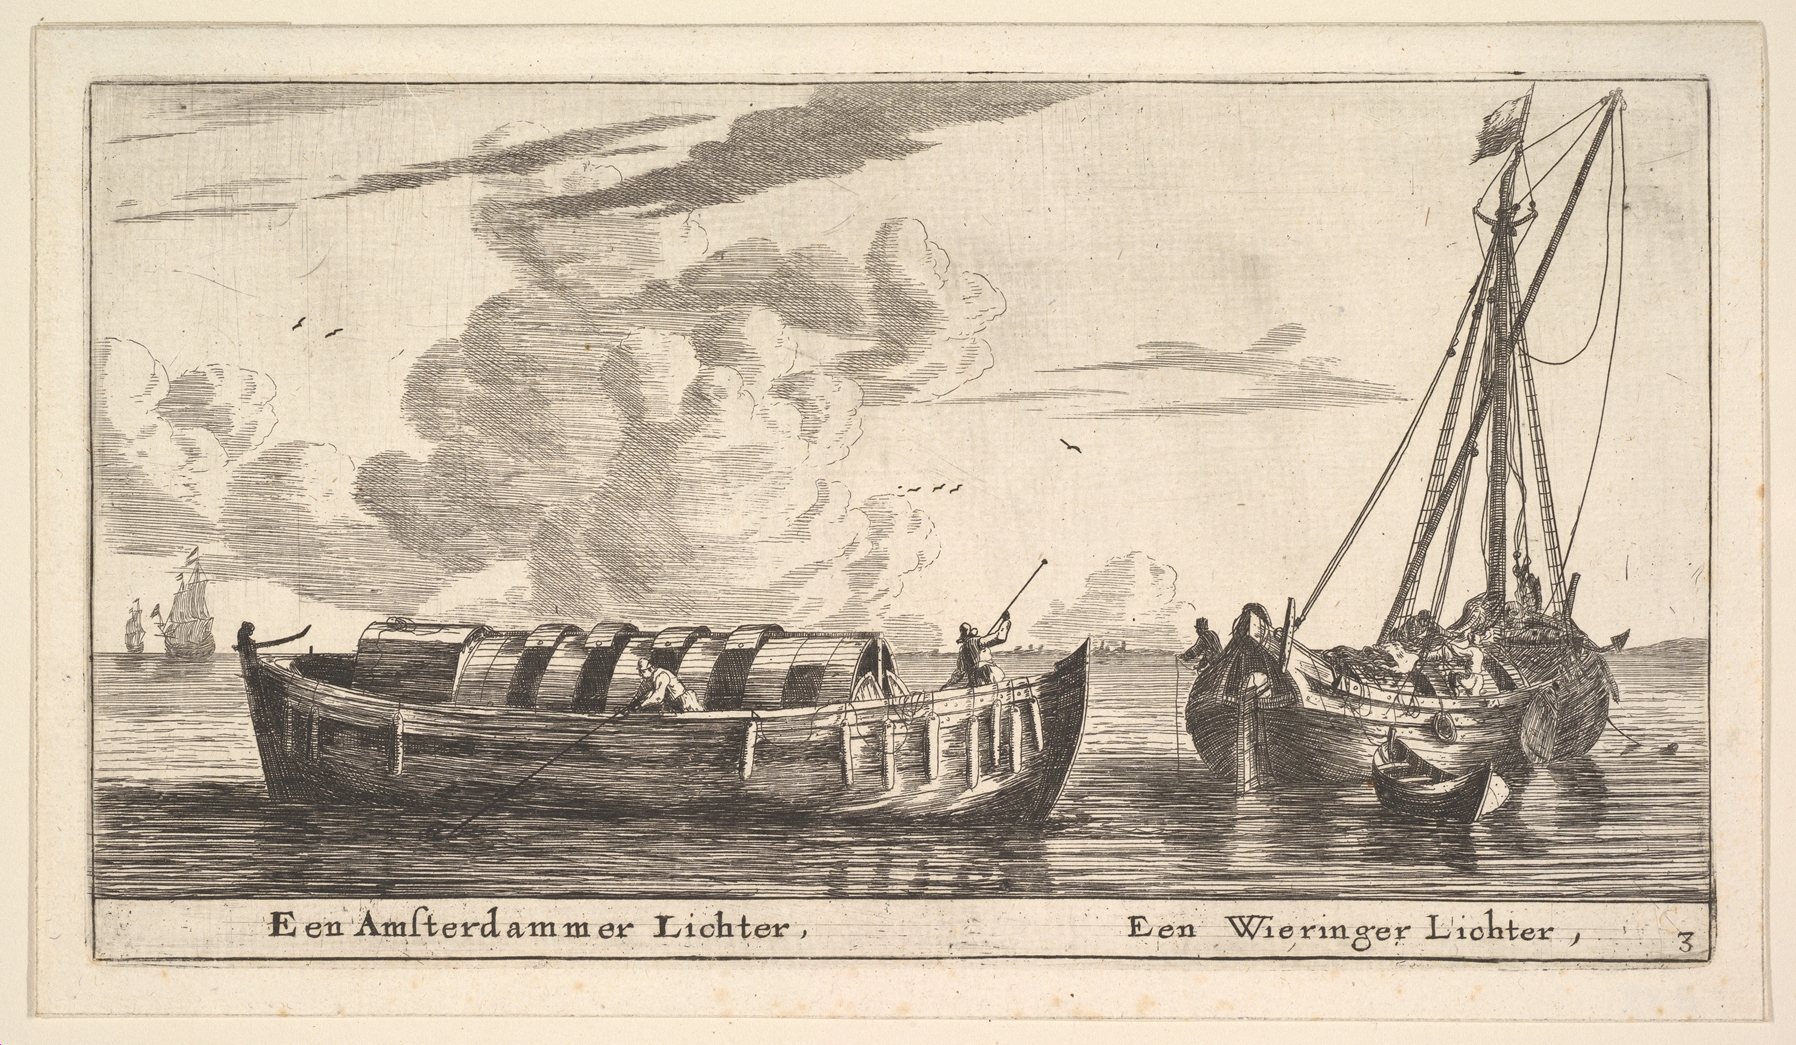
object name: print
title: An Amsterdam Lighter and a Wieringer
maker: reinier nooms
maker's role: artist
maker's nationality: dutch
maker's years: 1623-1664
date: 1601-1700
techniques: etching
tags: boats